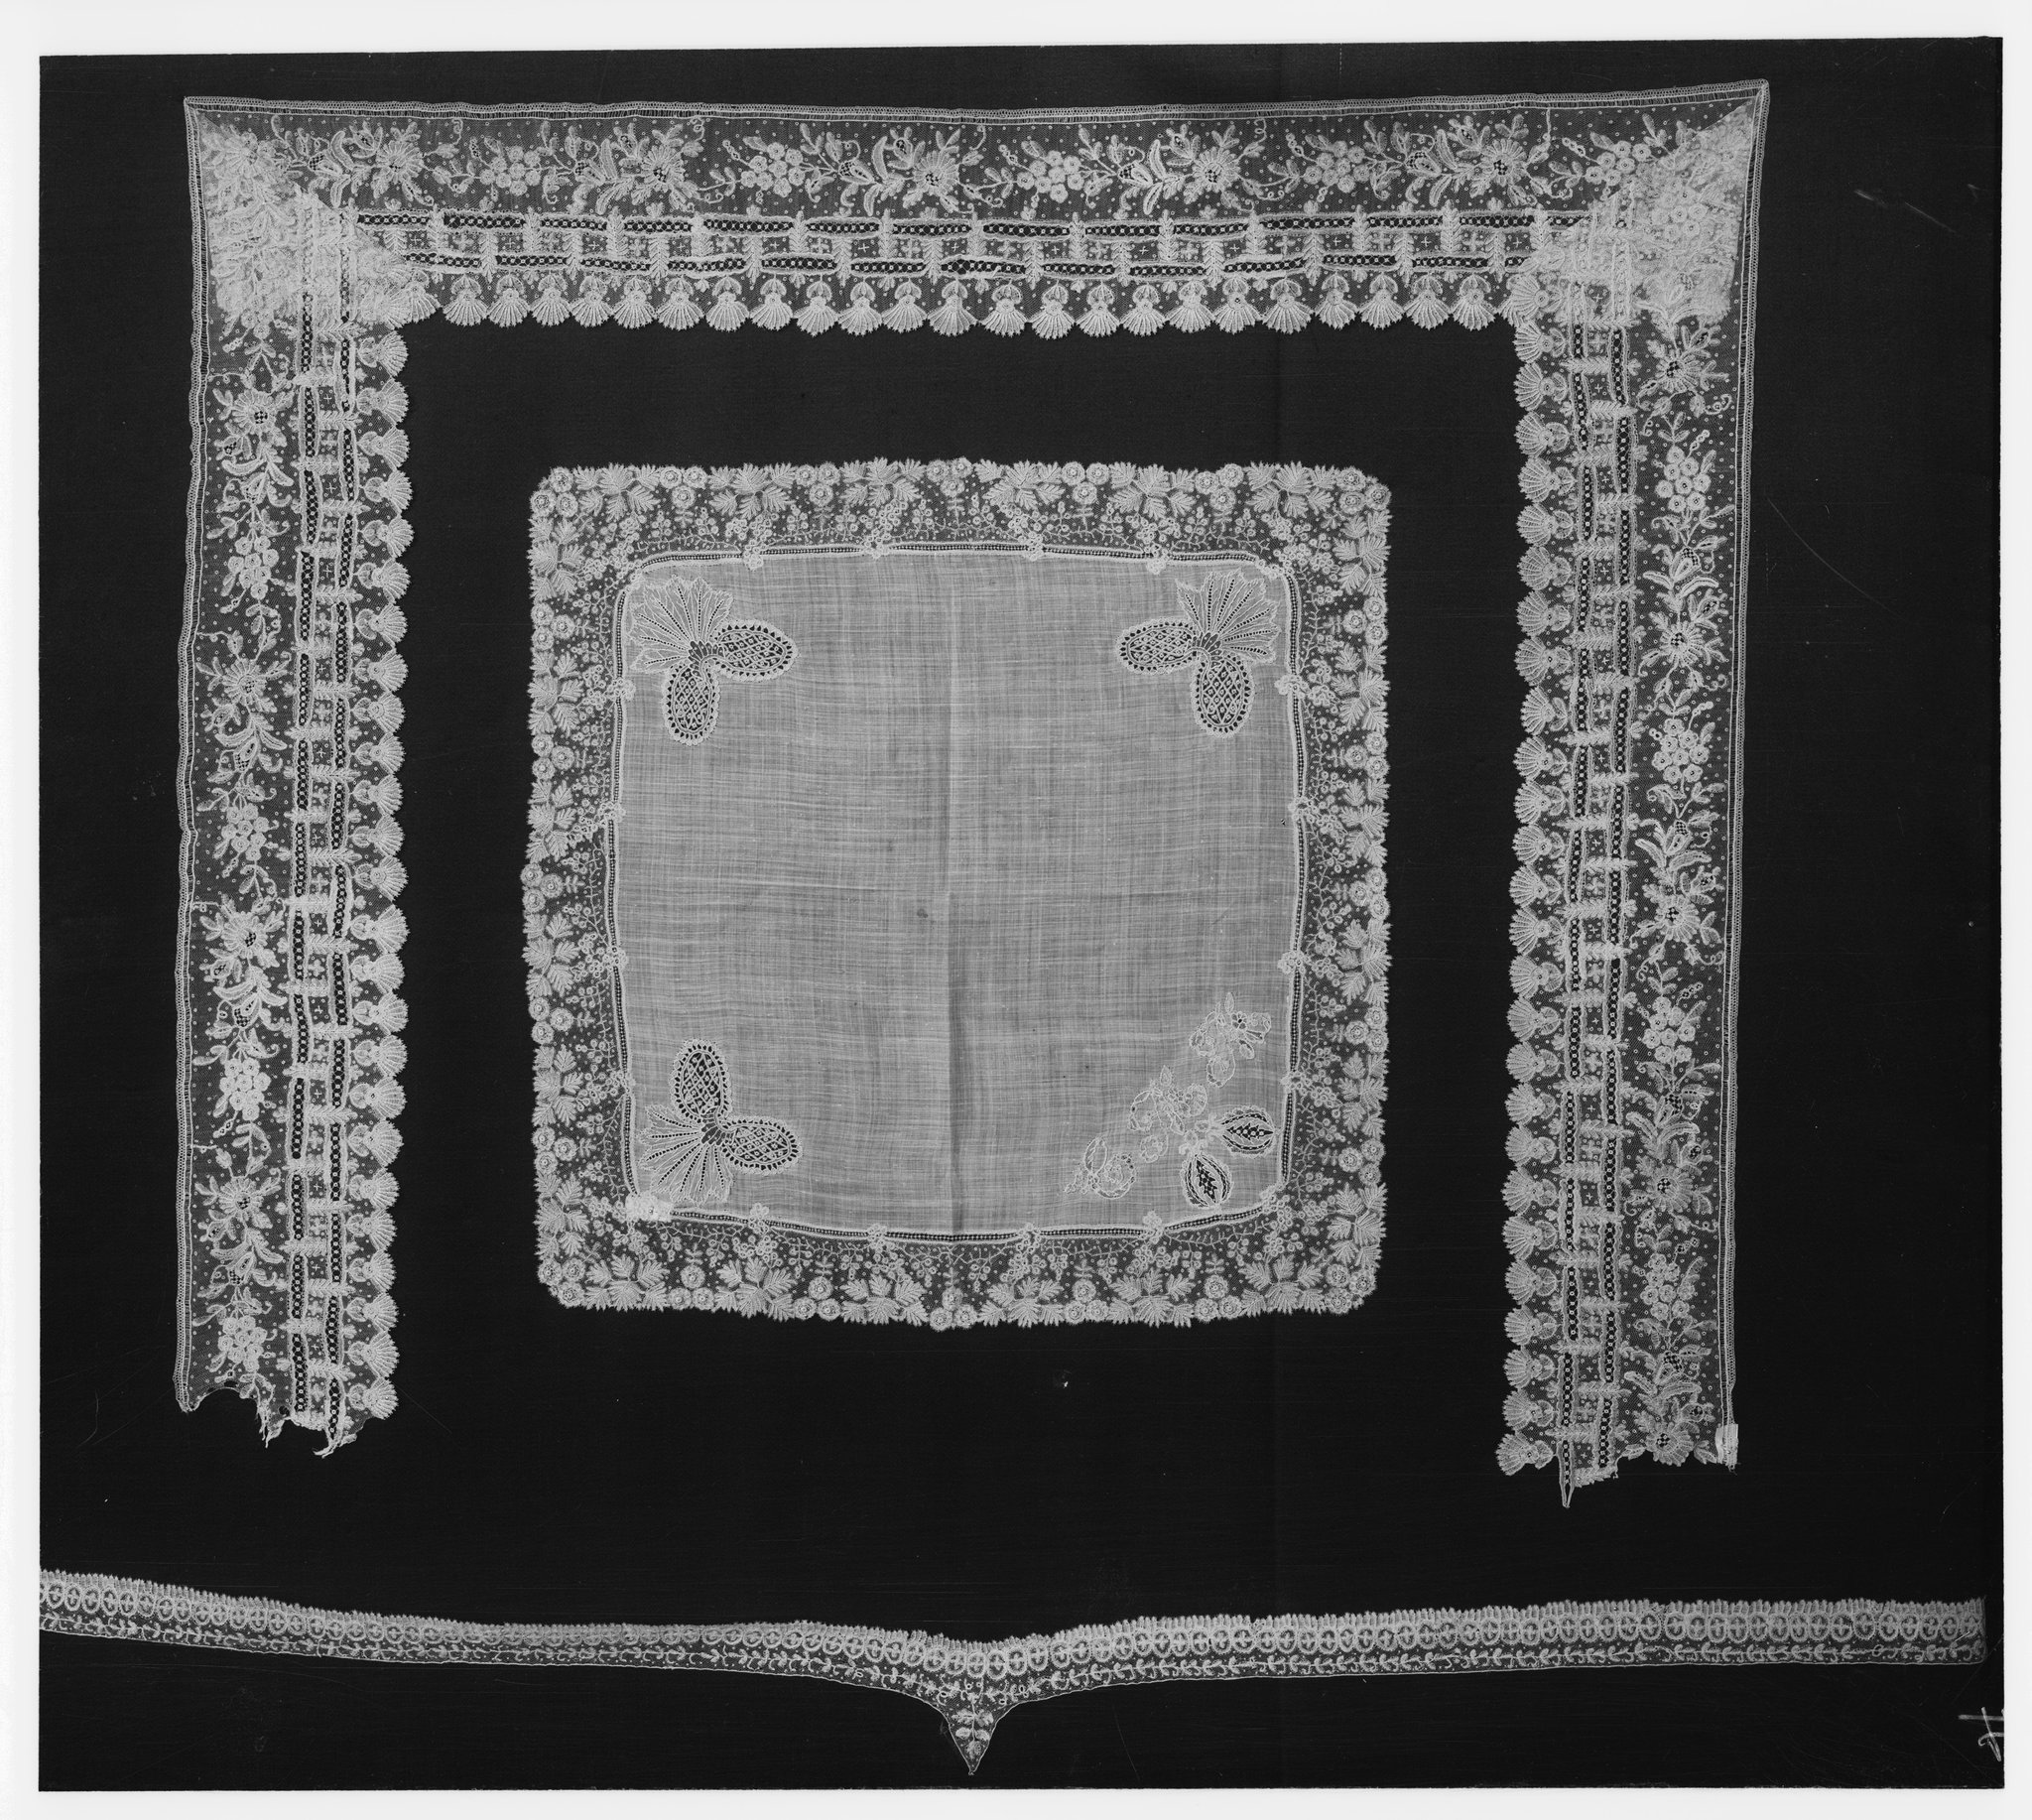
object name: handkerchief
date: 1870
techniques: lace